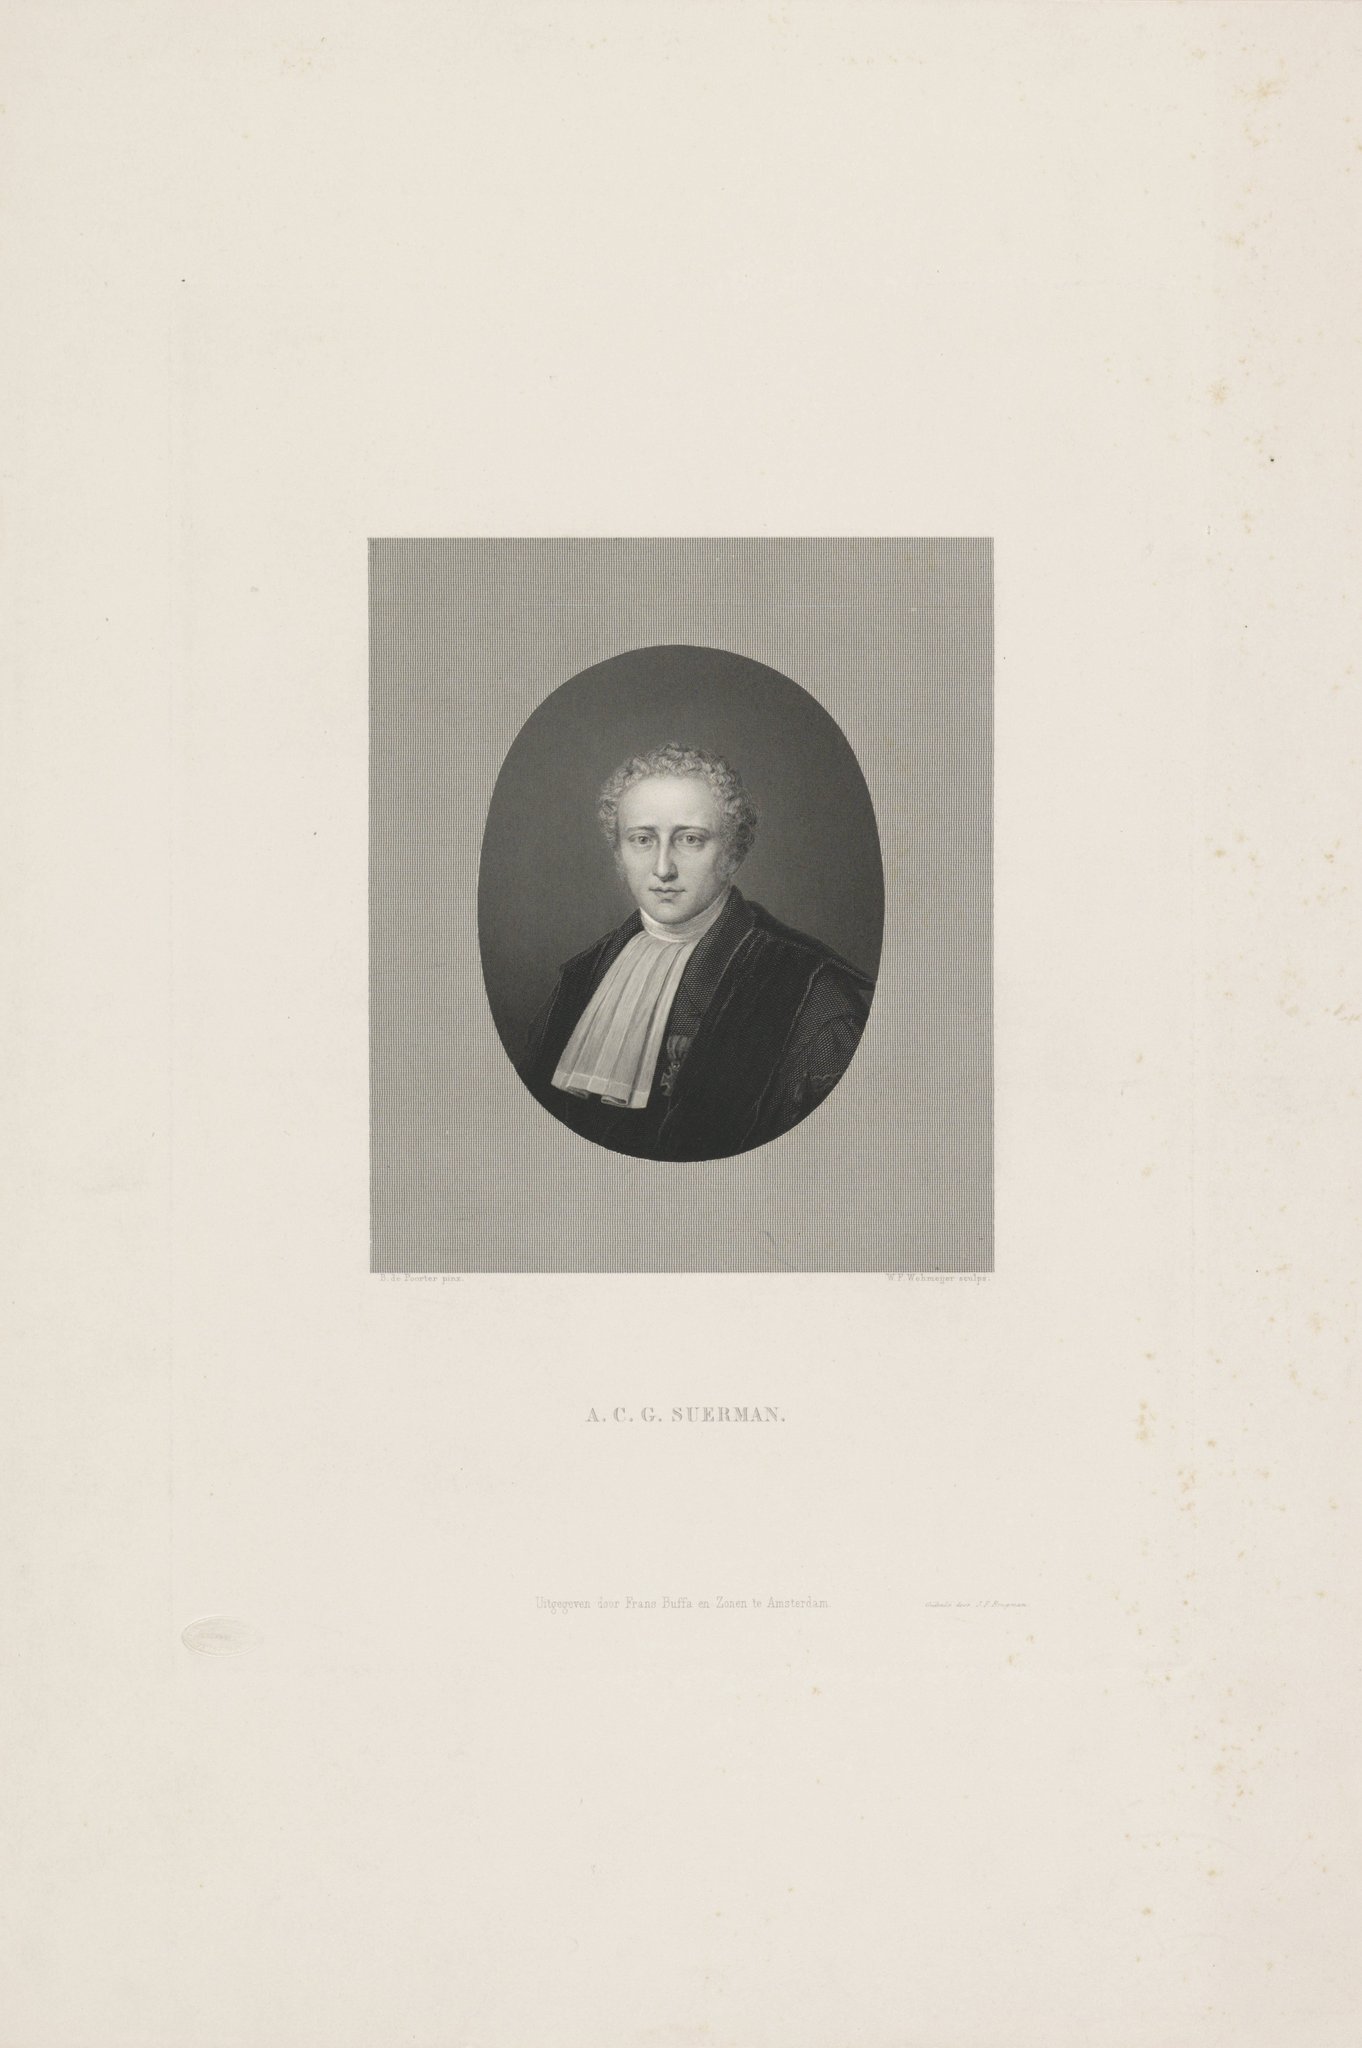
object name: print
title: Portret van Alexander Karel Willem Suerman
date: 1858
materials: paper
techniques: engraving, etching, roulette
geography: amsterdam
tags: utrecht, adult man, historical persons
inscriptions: collector's mark: Lugt 2228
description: Portret van Alexander Karel Willem Suerman, hoogleraar geneeskunde aan de Utrechtse Hogeschool. Hij draagt een toga. Onder de voorstelling bevindt zich de naam van de geportretteerde.